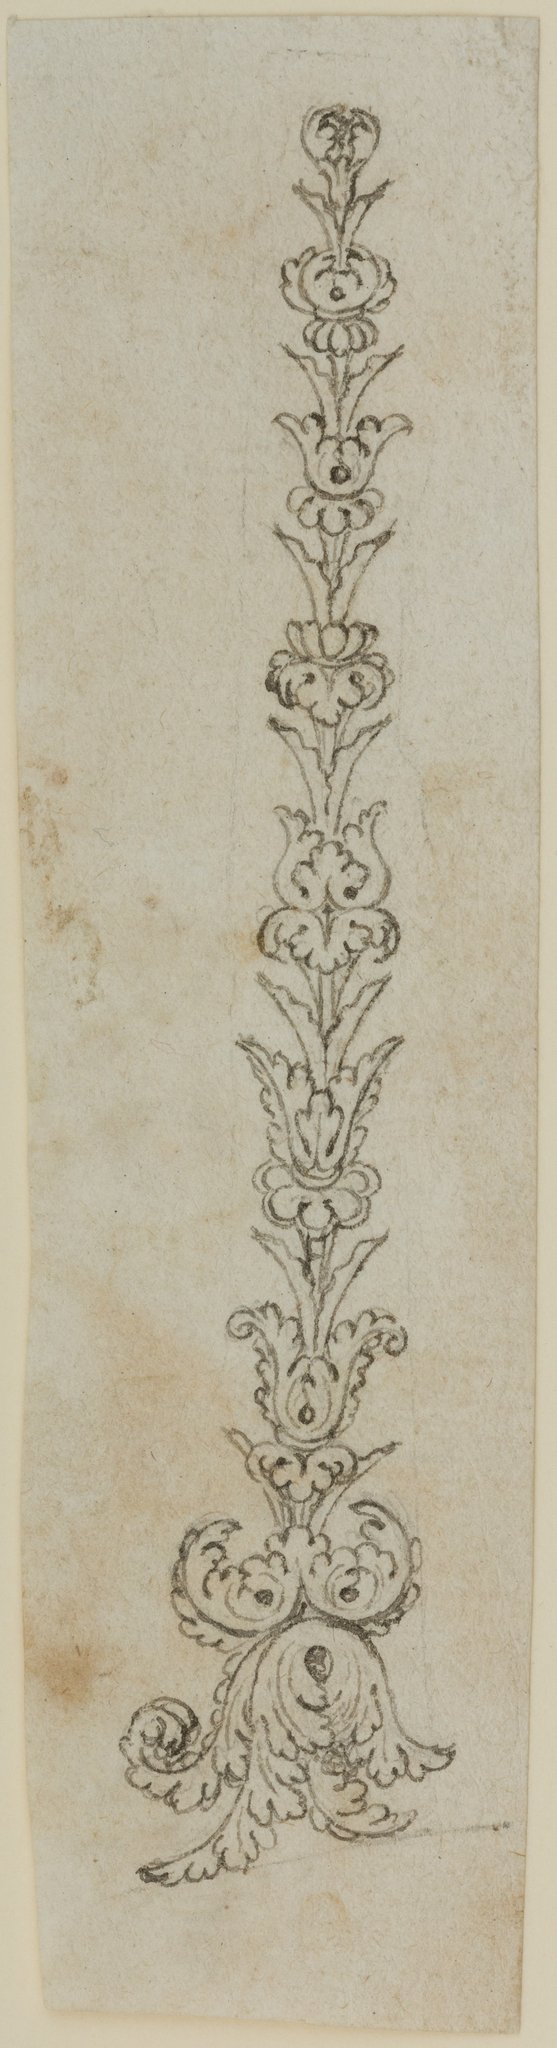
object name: drawing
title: Design for the Decoration of Firearms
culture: french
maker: nicolas noël boutet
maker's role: designer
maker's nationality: french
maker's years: 1761-1833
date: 1797-1805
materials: ink, paper, pencil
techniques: wash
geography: france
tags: ornament